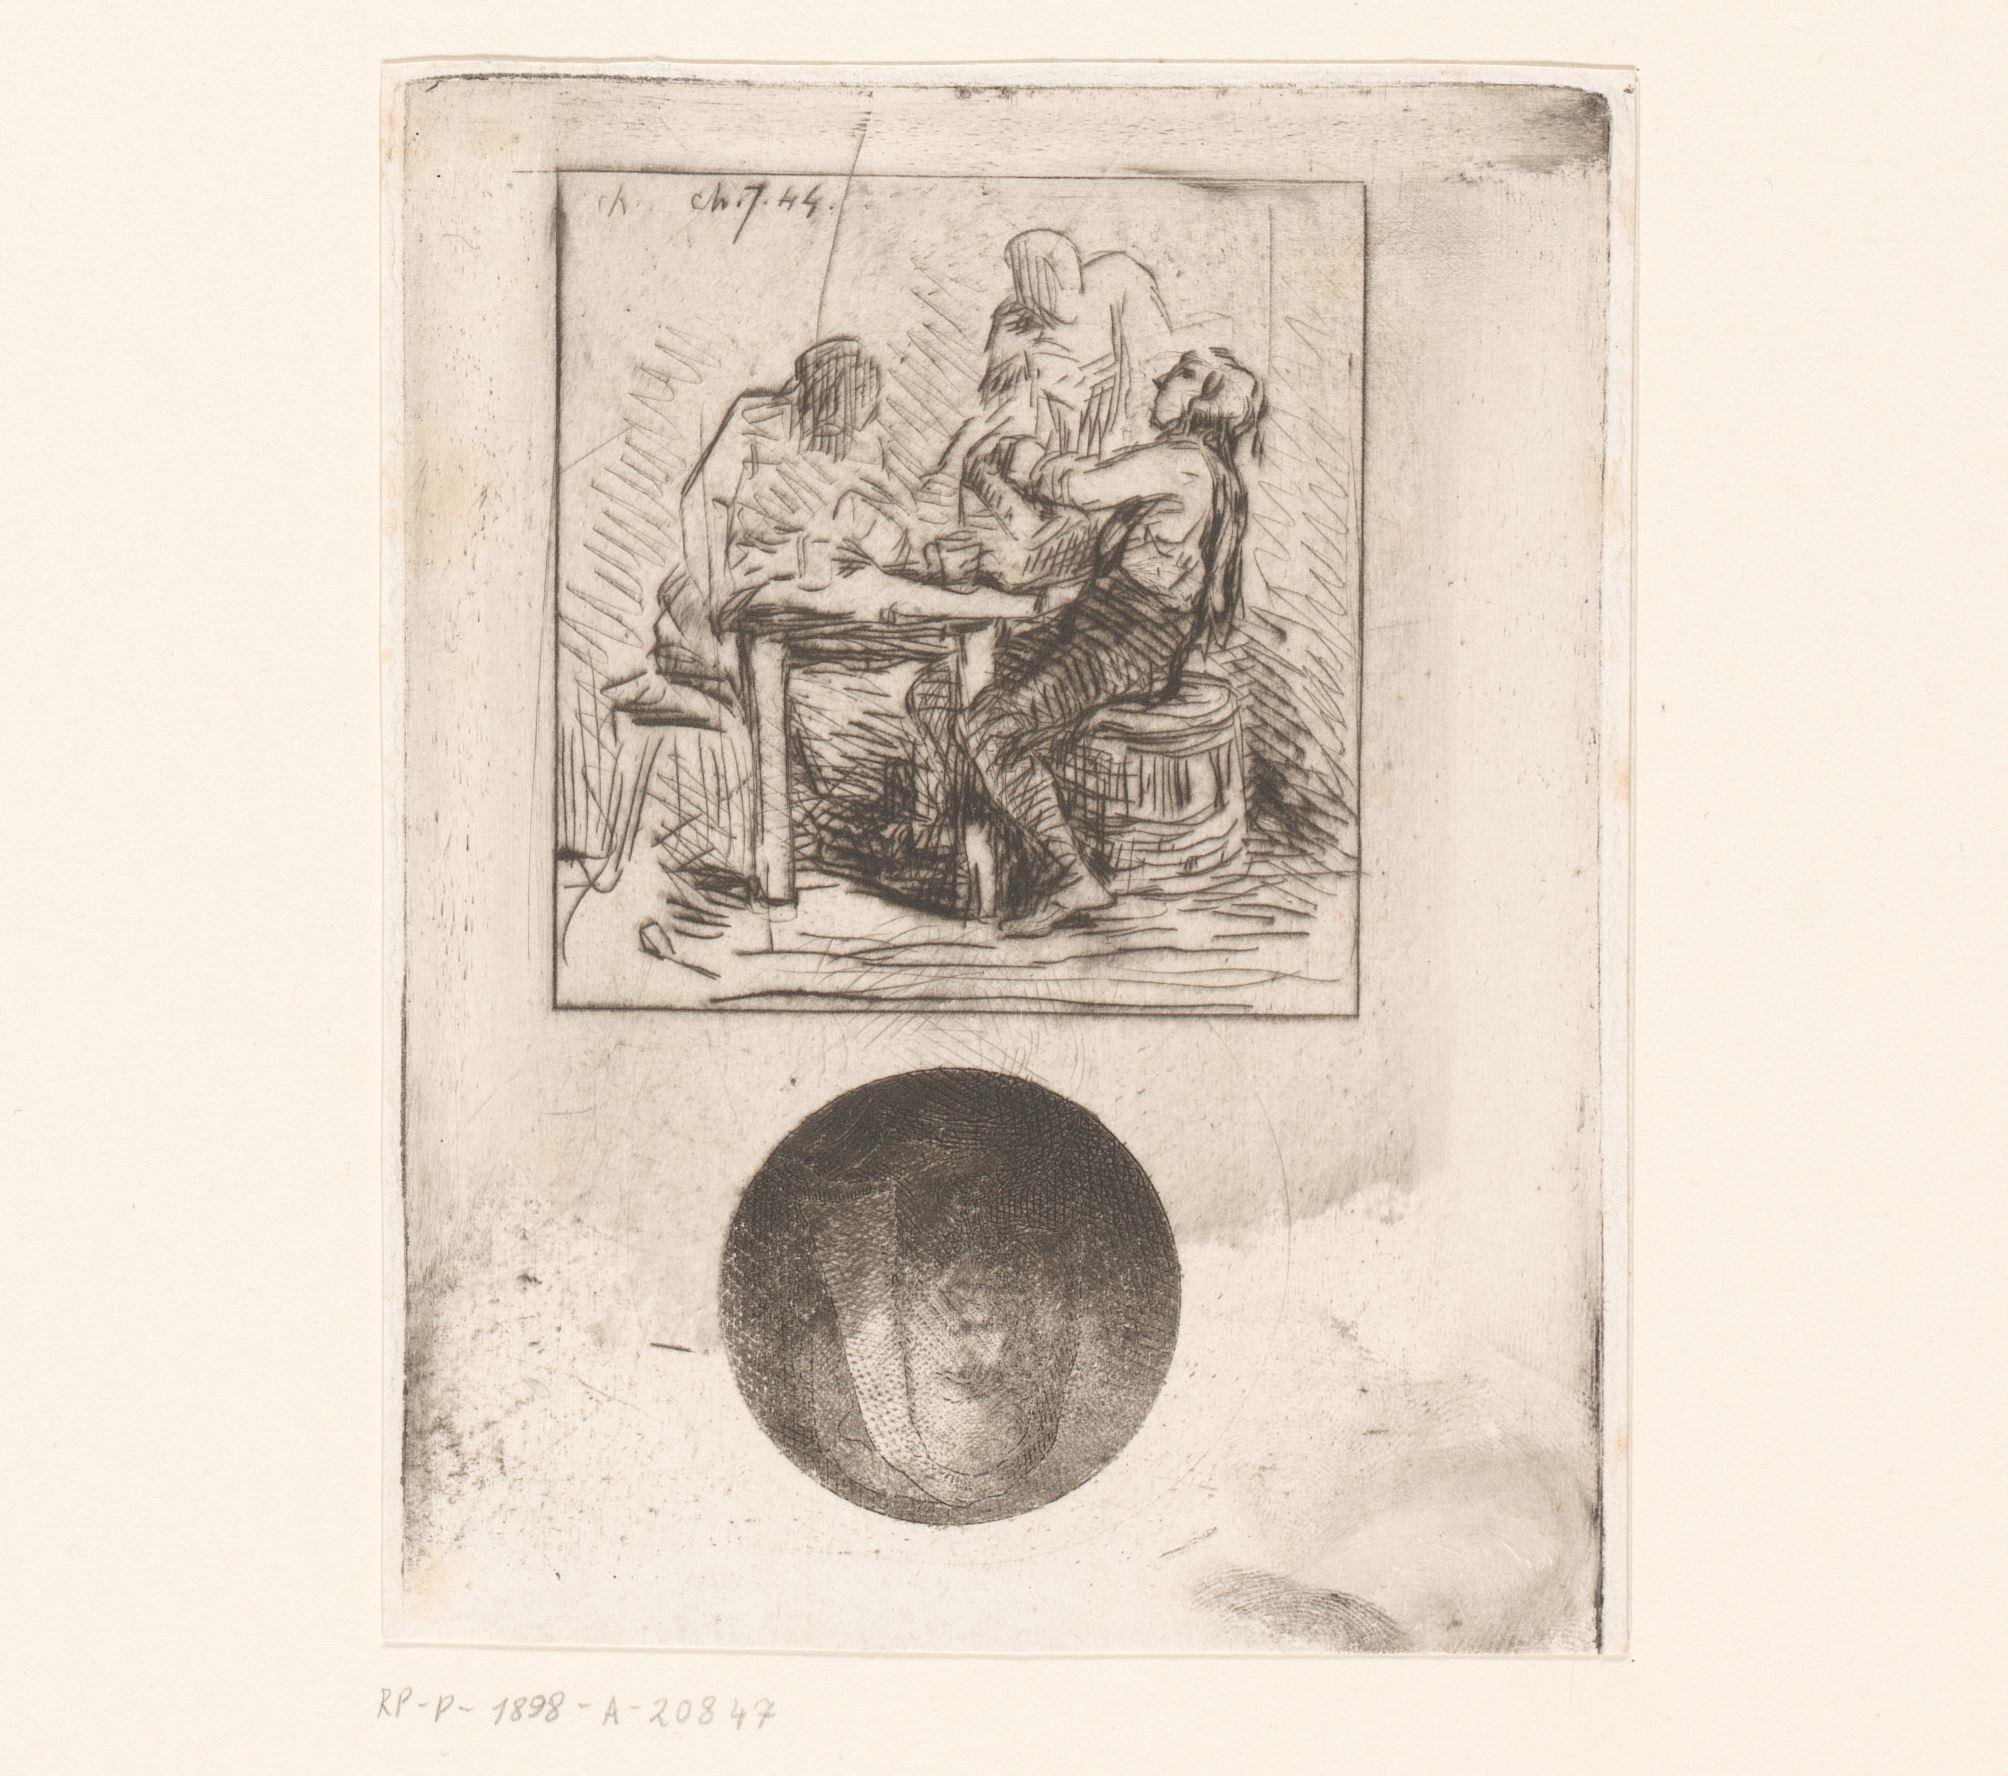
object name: print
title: Drie figuren aan een tafel met onderaan een portret van een vrouw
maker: charles emile jacque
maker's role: draughtsman, painter, print maker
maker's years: 1813-1894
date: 1844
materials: paper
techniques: drypoint, etching, roulette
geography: france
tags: historical persons - bb - woman, table, drinking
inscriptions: collector's mark: Lugt 964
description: Het Rijksmuseum bezit drie staten van deze prent. Zie ook RP-P-1898-A-20845 en RP-P-1898-A-20846.